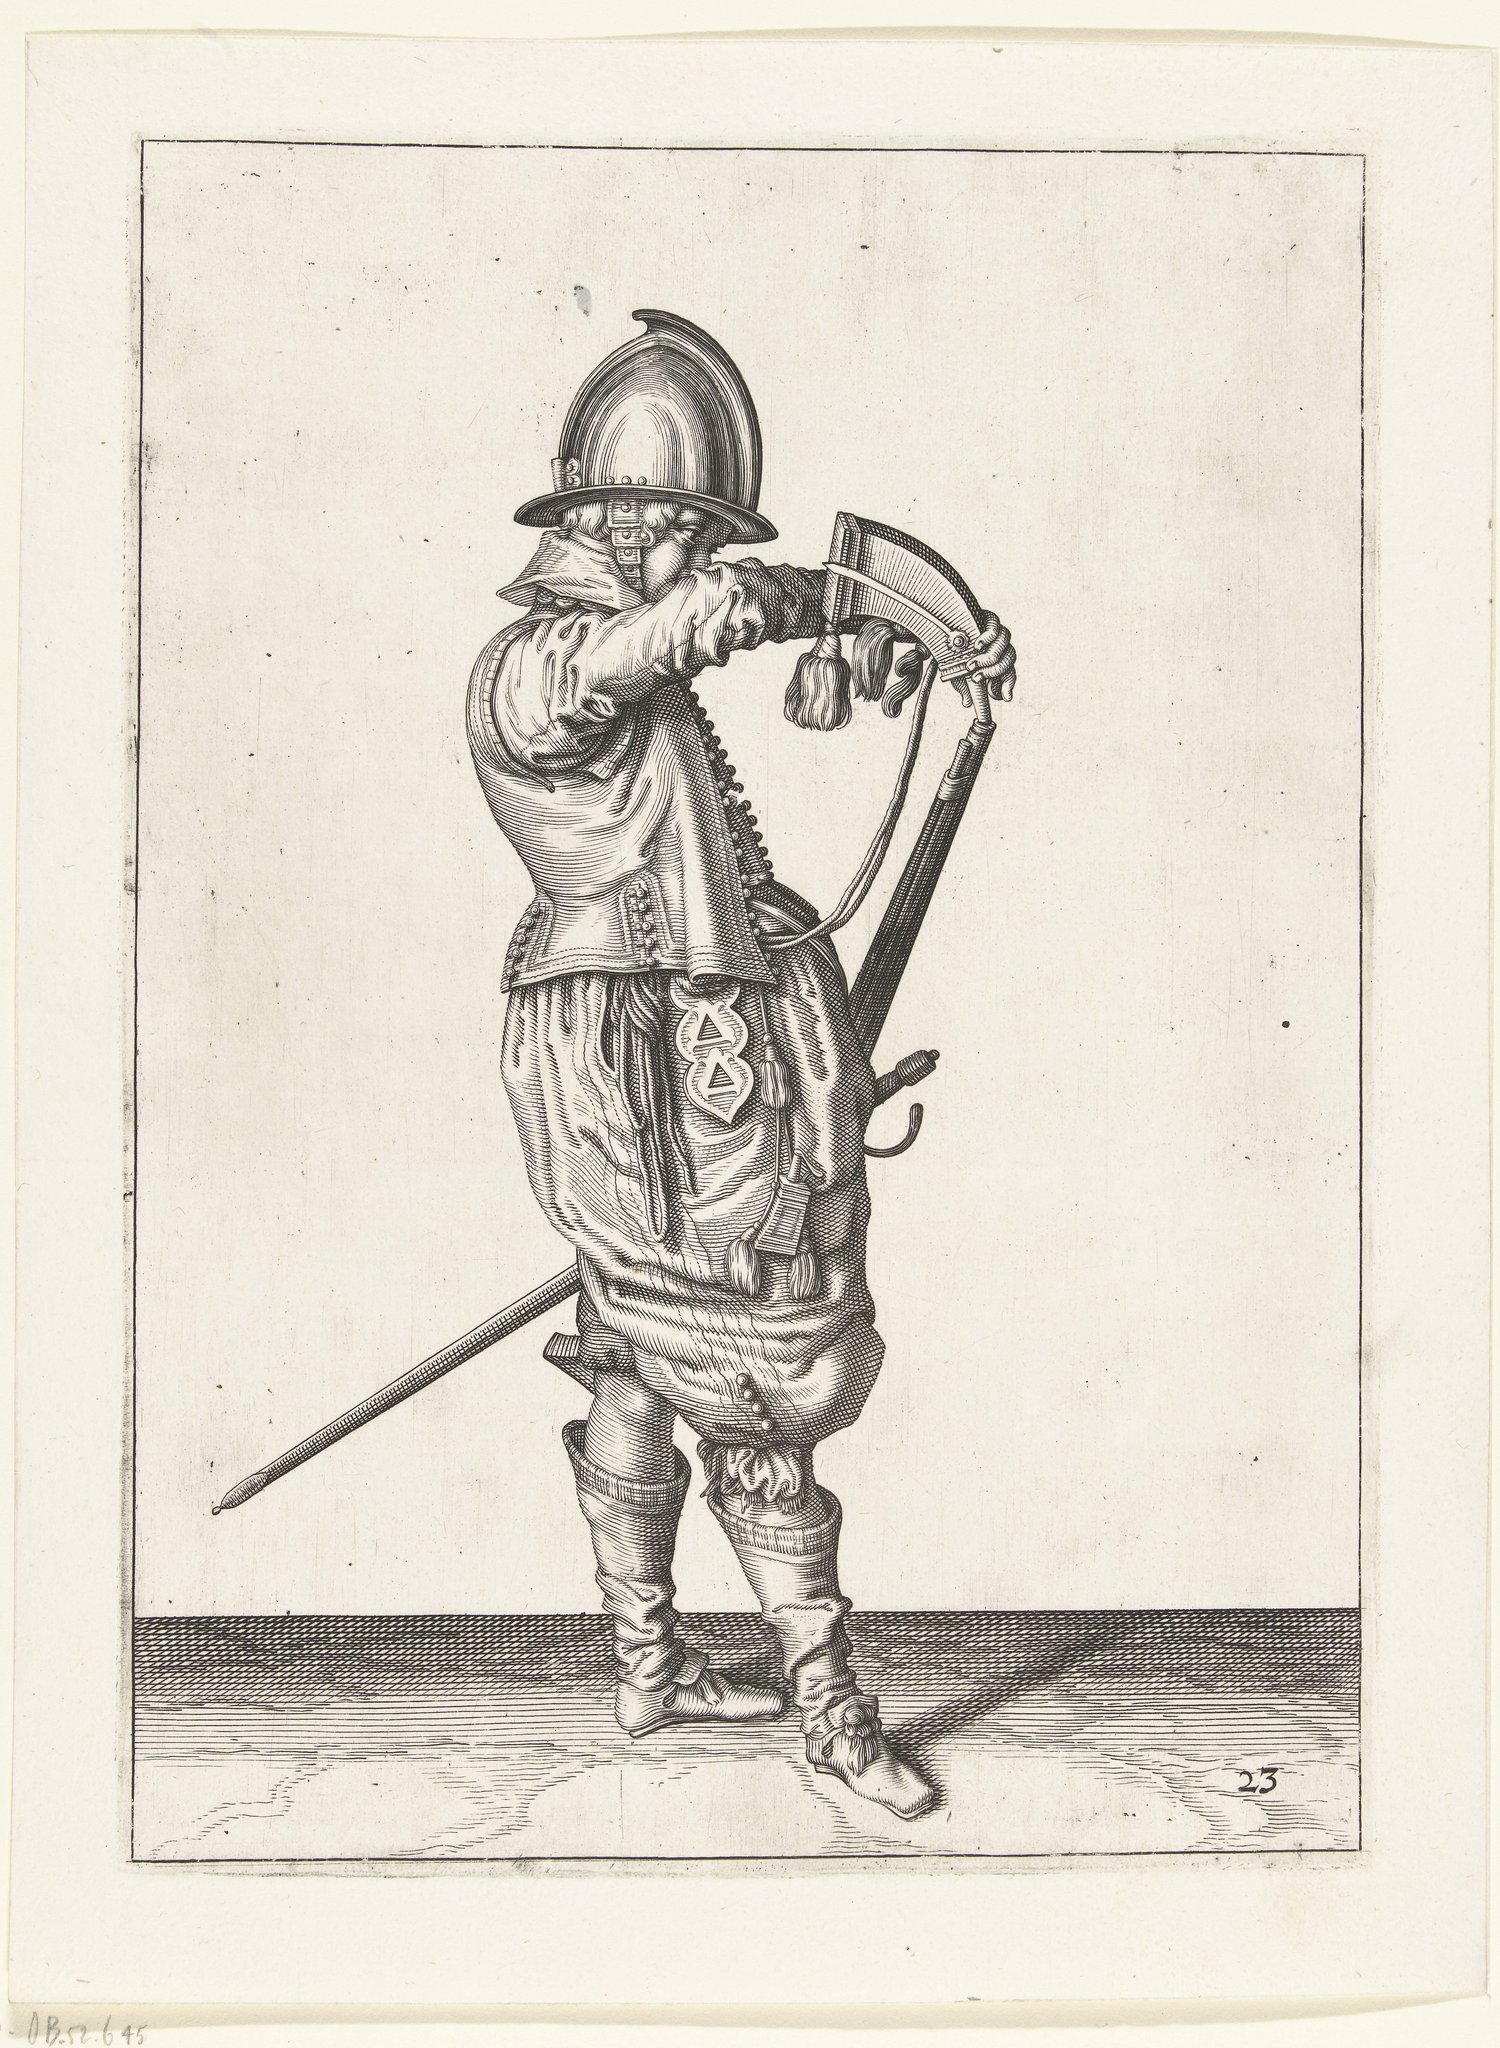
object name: print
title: Soldaat die kruit in de loop van zijn roer giet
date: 1597-1607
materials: paper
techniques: engraving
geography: netherlands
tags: manoeuvre ~ military training, firearms: rifle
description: Een soldaat, ten voeten uit, naar rechts, die met zijn linkerhand bij zijn linkerdijbeen een roer (een bepaald type vuurwapen) vasthoudt. Met zijn rechterhand giet hij kruit uit een kruithoorn in de loop, die schuin omhoog wijst. Deze prent is onderdeel van de reeks van 42 genummerde prenten van roerschutters uit de Wapenhandelinghe.